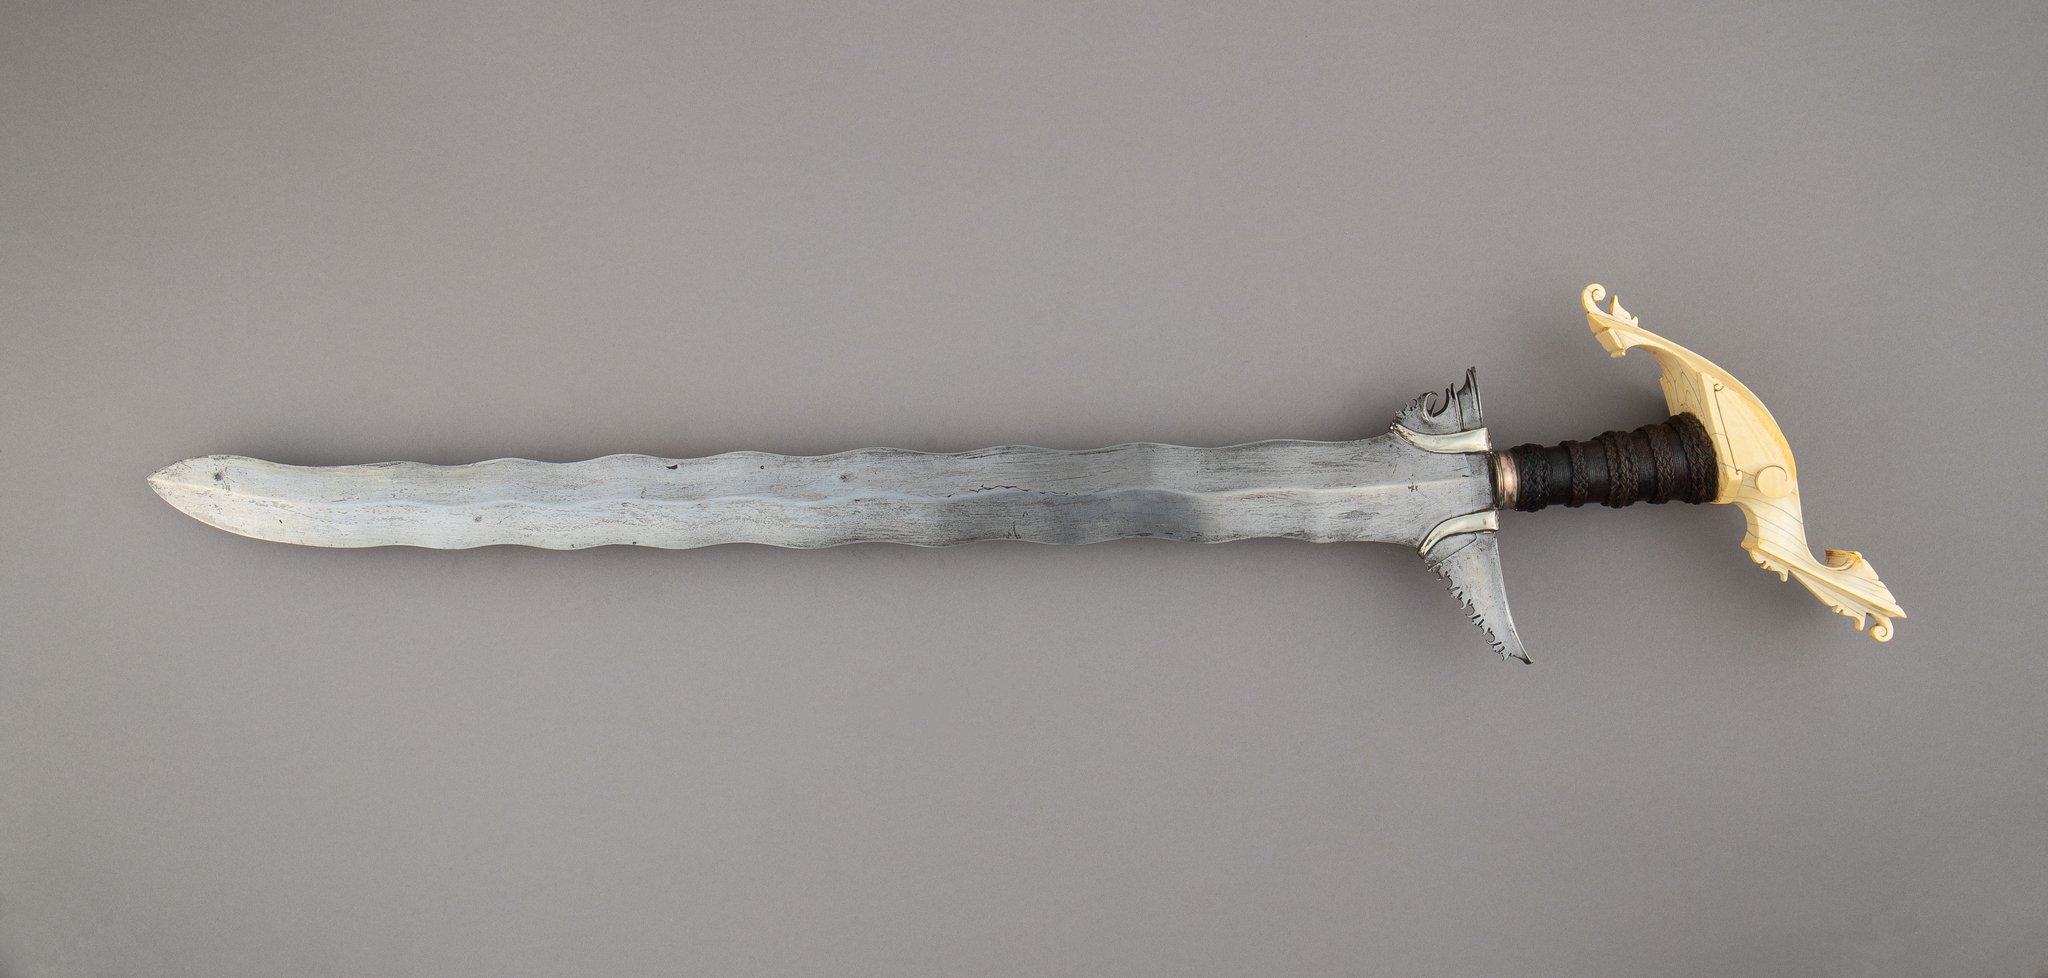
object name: kris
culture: philippine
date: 1701-1900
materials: cord, ivory, silver, steel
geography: philippines